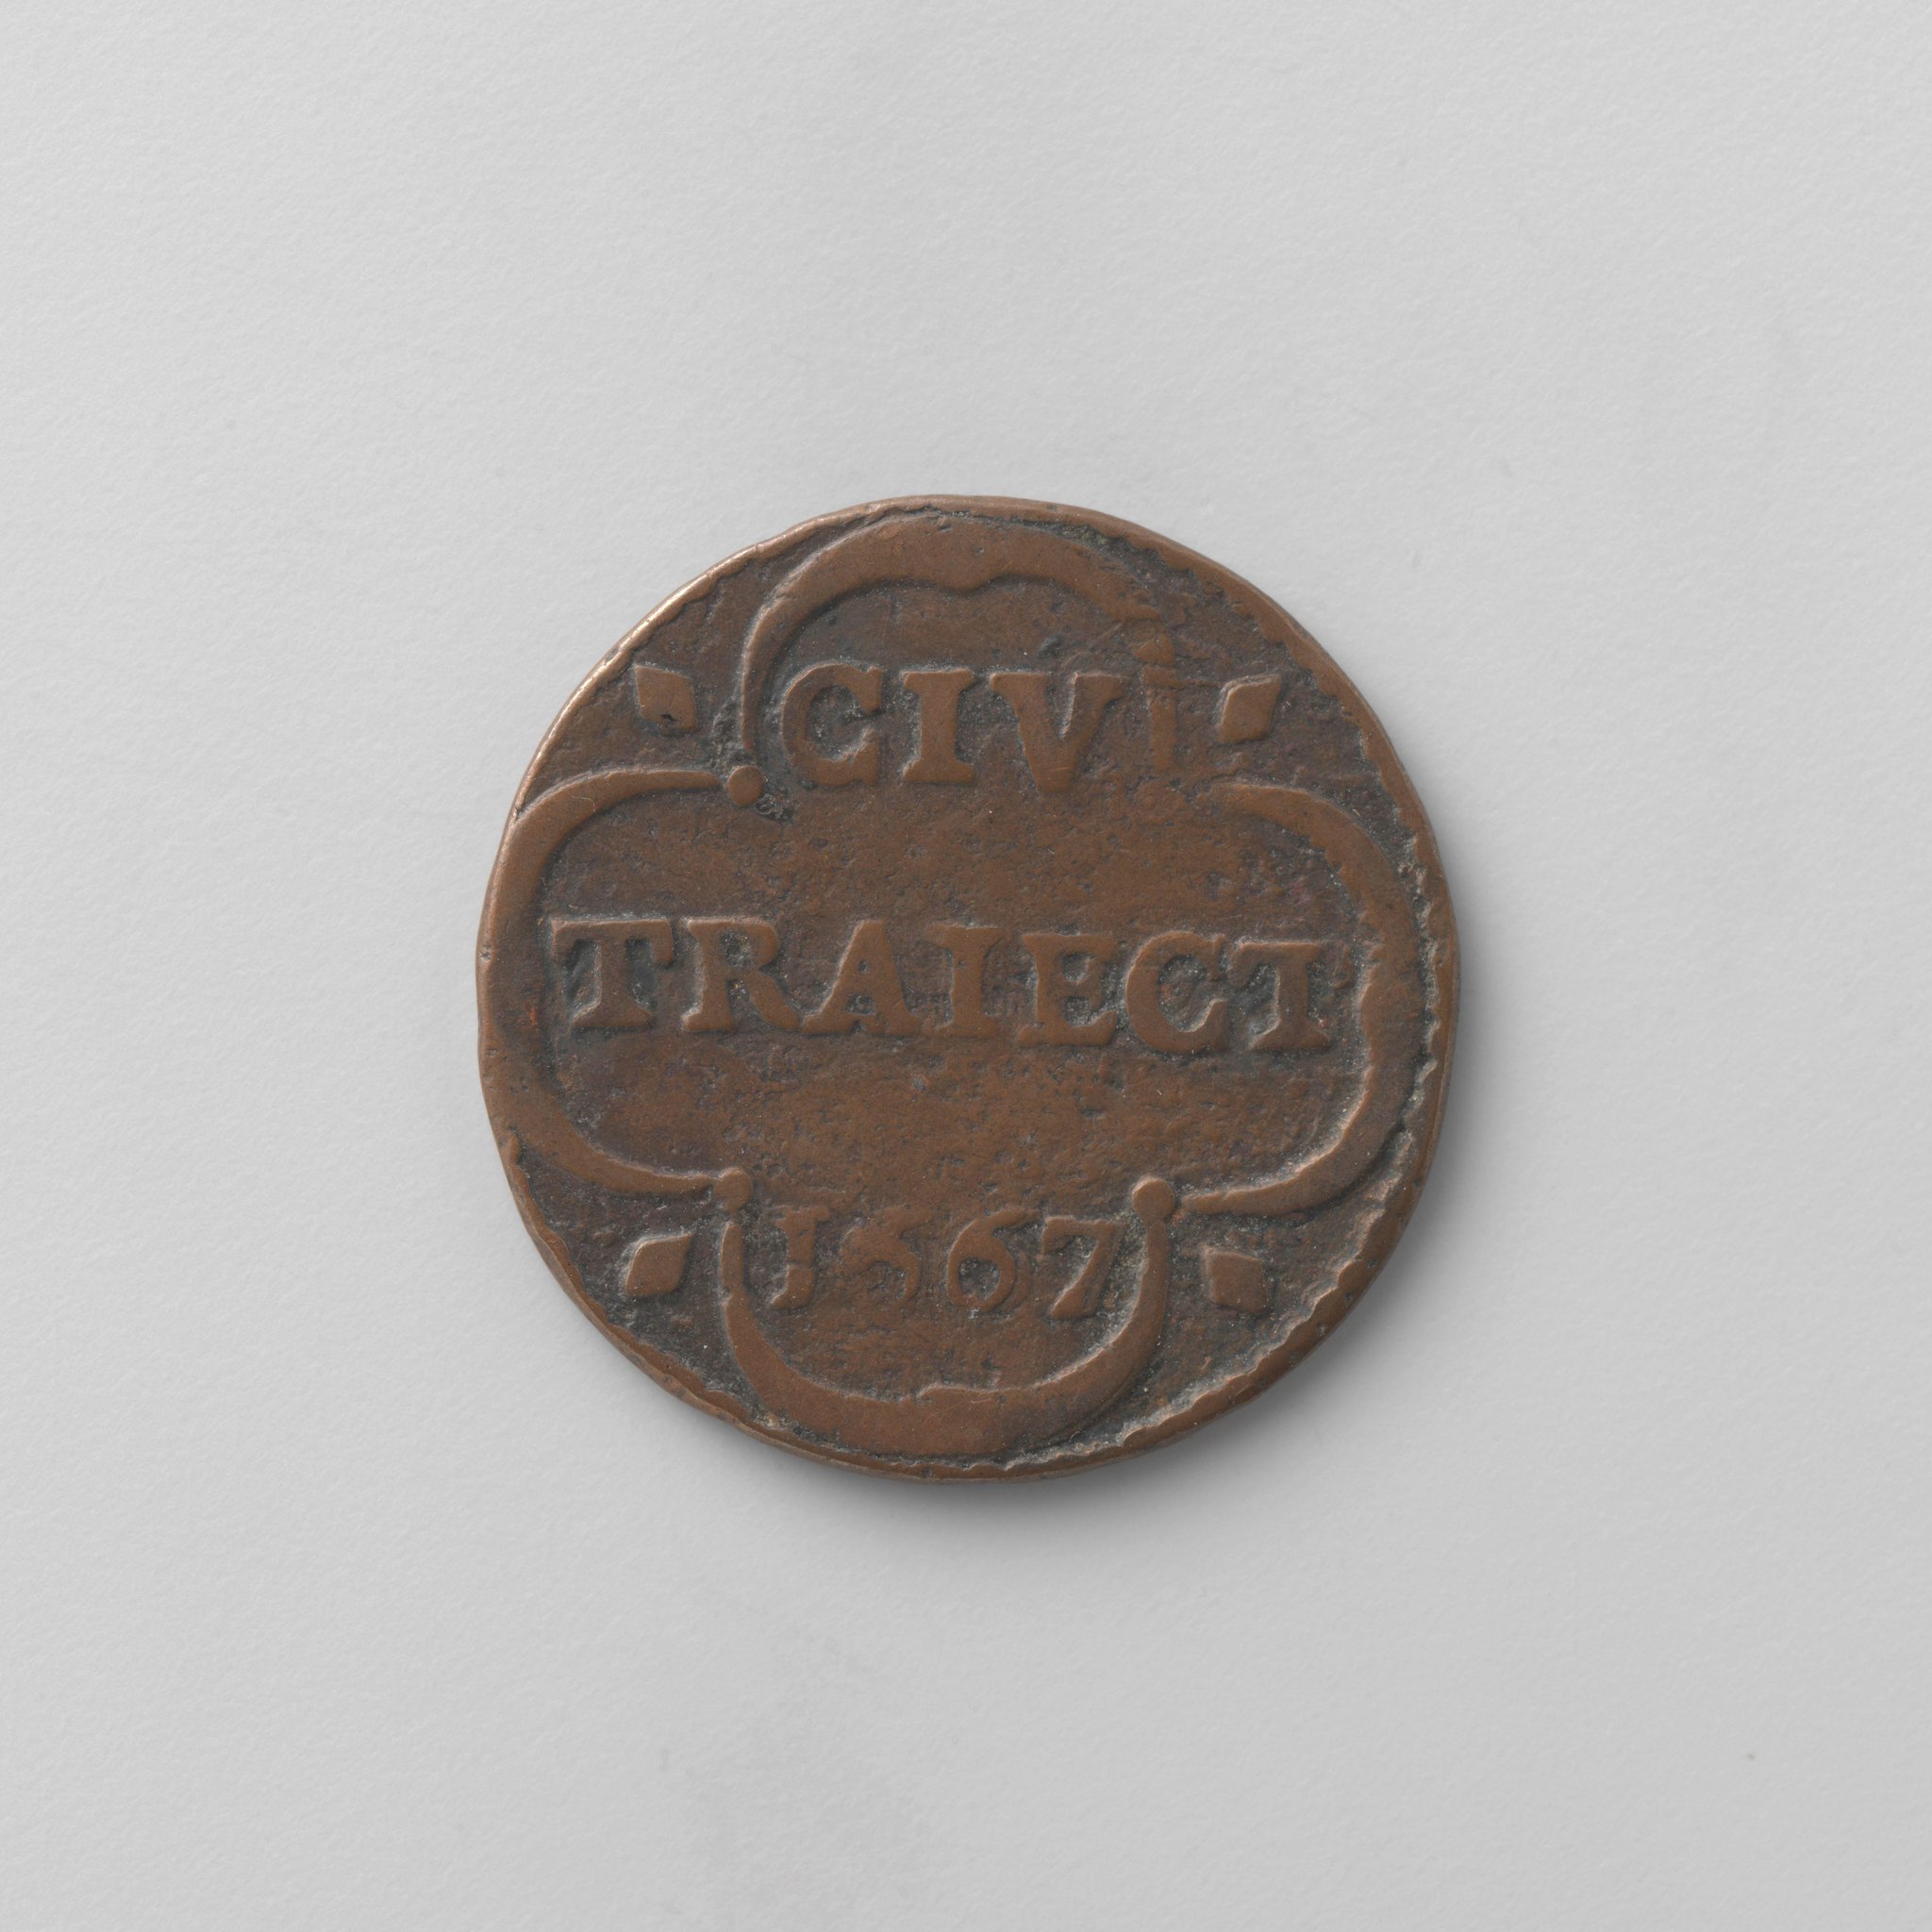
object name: coin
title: Duit van de stad Utrecht, 1667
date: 1667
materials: copper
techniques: striking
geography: utrecht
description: Koperen munt. Voorzijde: gekroond stedelijk, horizontaal gearceeerd wapenschild, gehouden door twee leeuwen. Keerzijde: binnen een versierde vierpas opschrift in twee regels, waaronder jaartal.